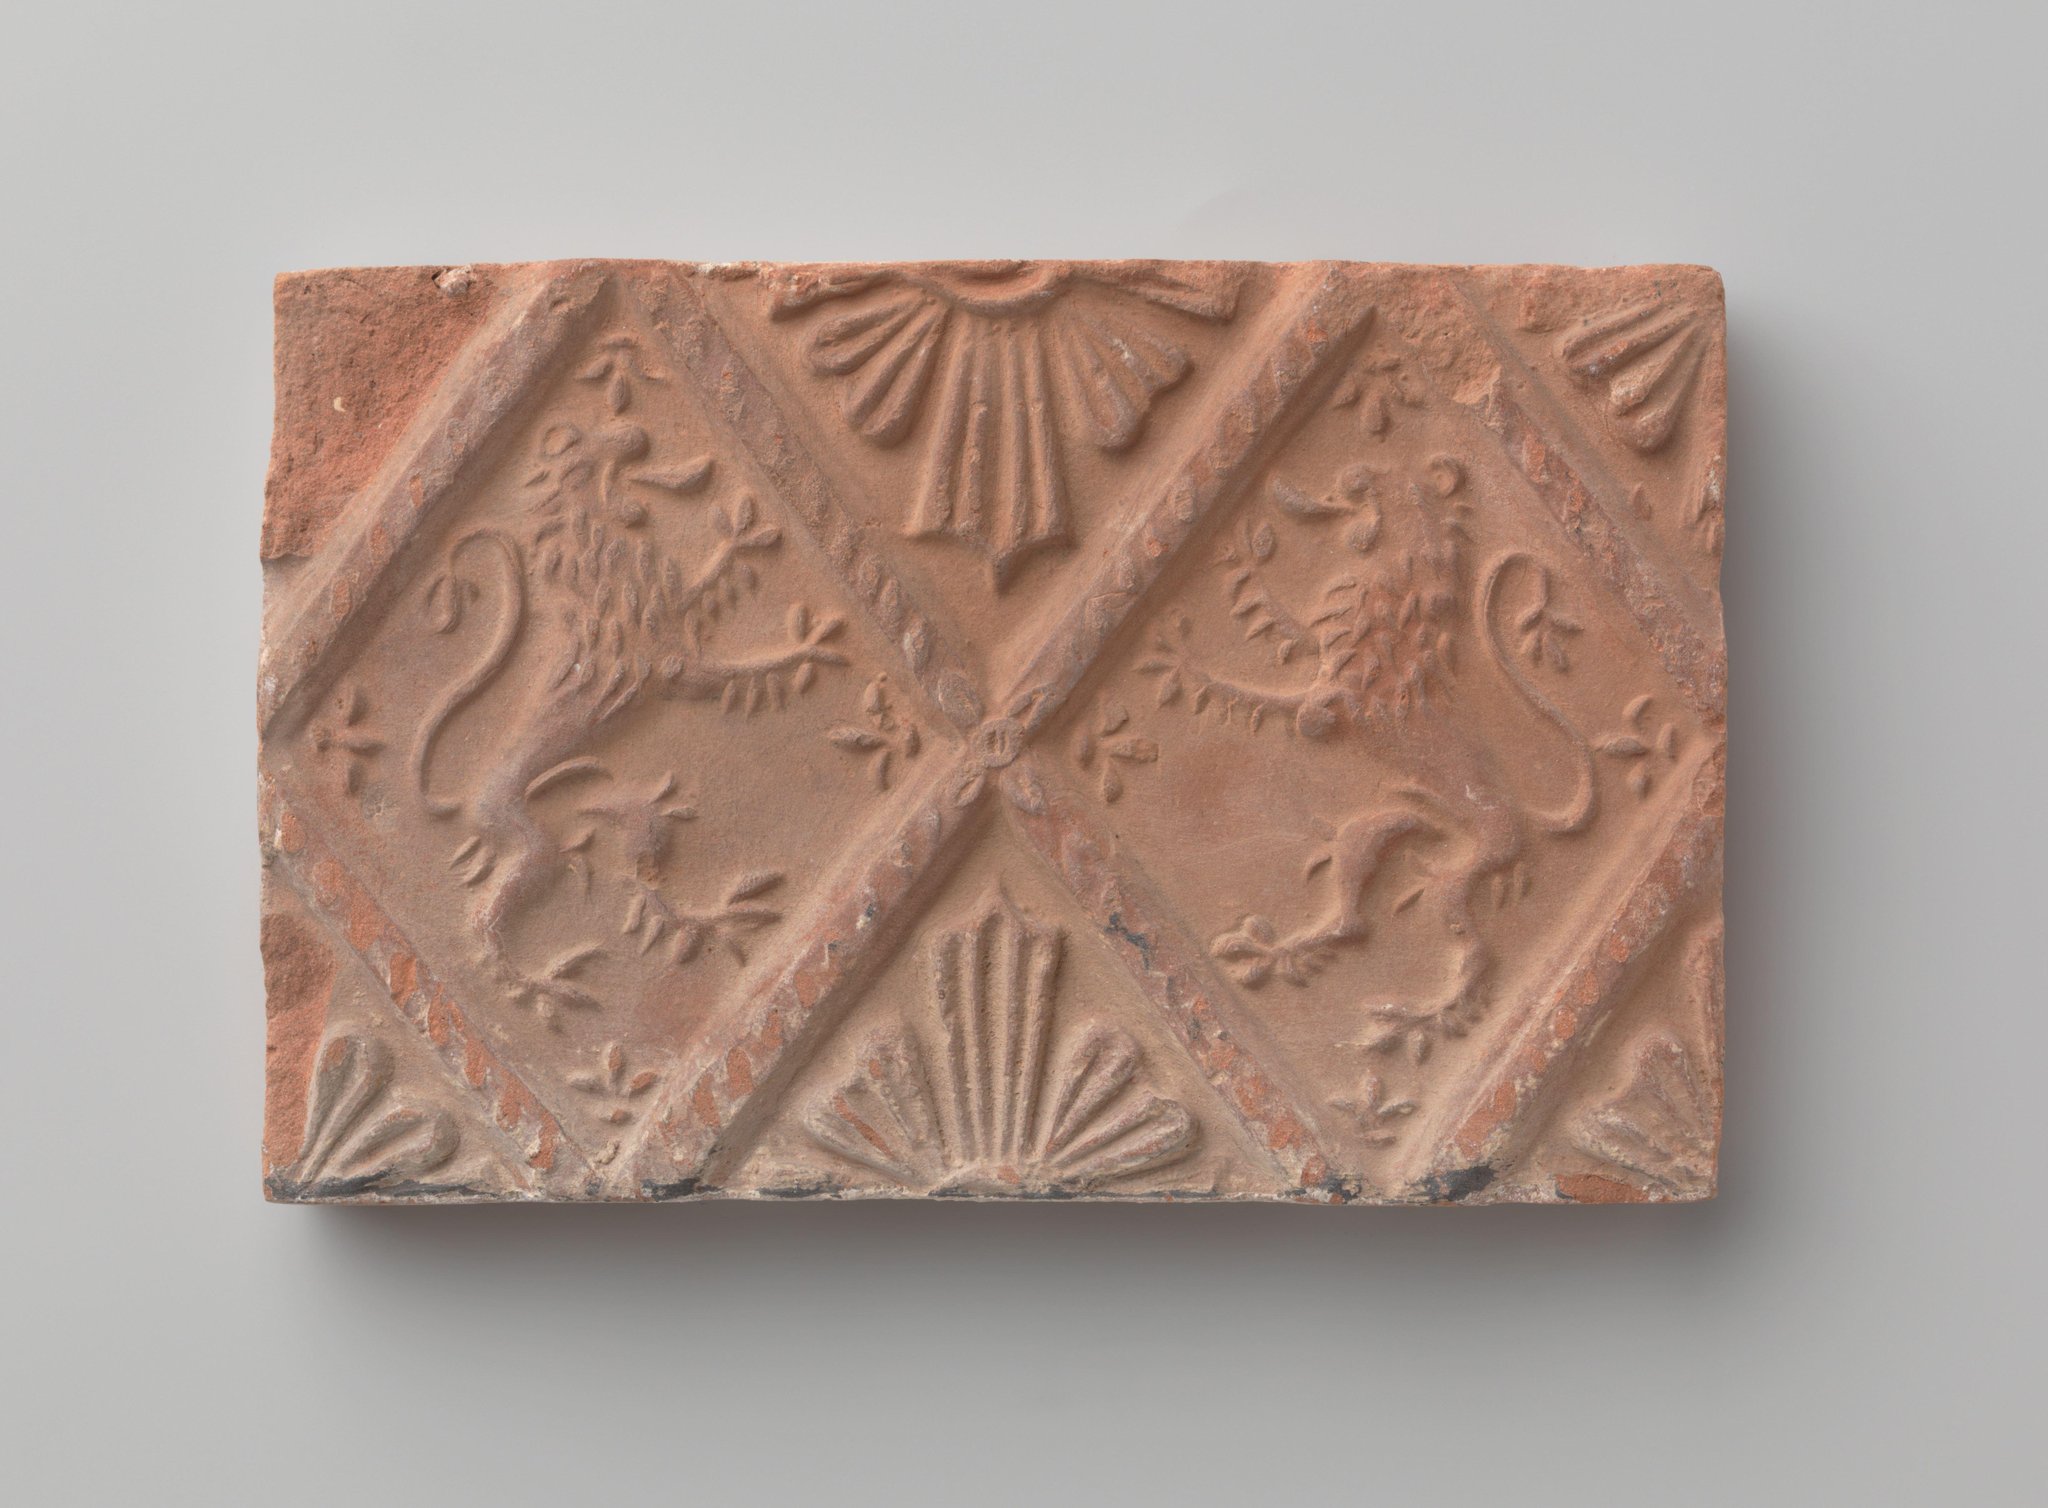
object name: hearthstone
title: Haardsteen met voorstelling van twee klimmende leeuwen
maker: Anonymous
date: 1875-1900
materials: earthenware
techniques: printing, firing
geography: netherlands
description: Haardsteen met voorstelling van twee klimmende leeuwen, geplaatst in geprofileerde ruit. De halve ruiten aan de boven- en onderkant zijn opgevuld met stermotief.